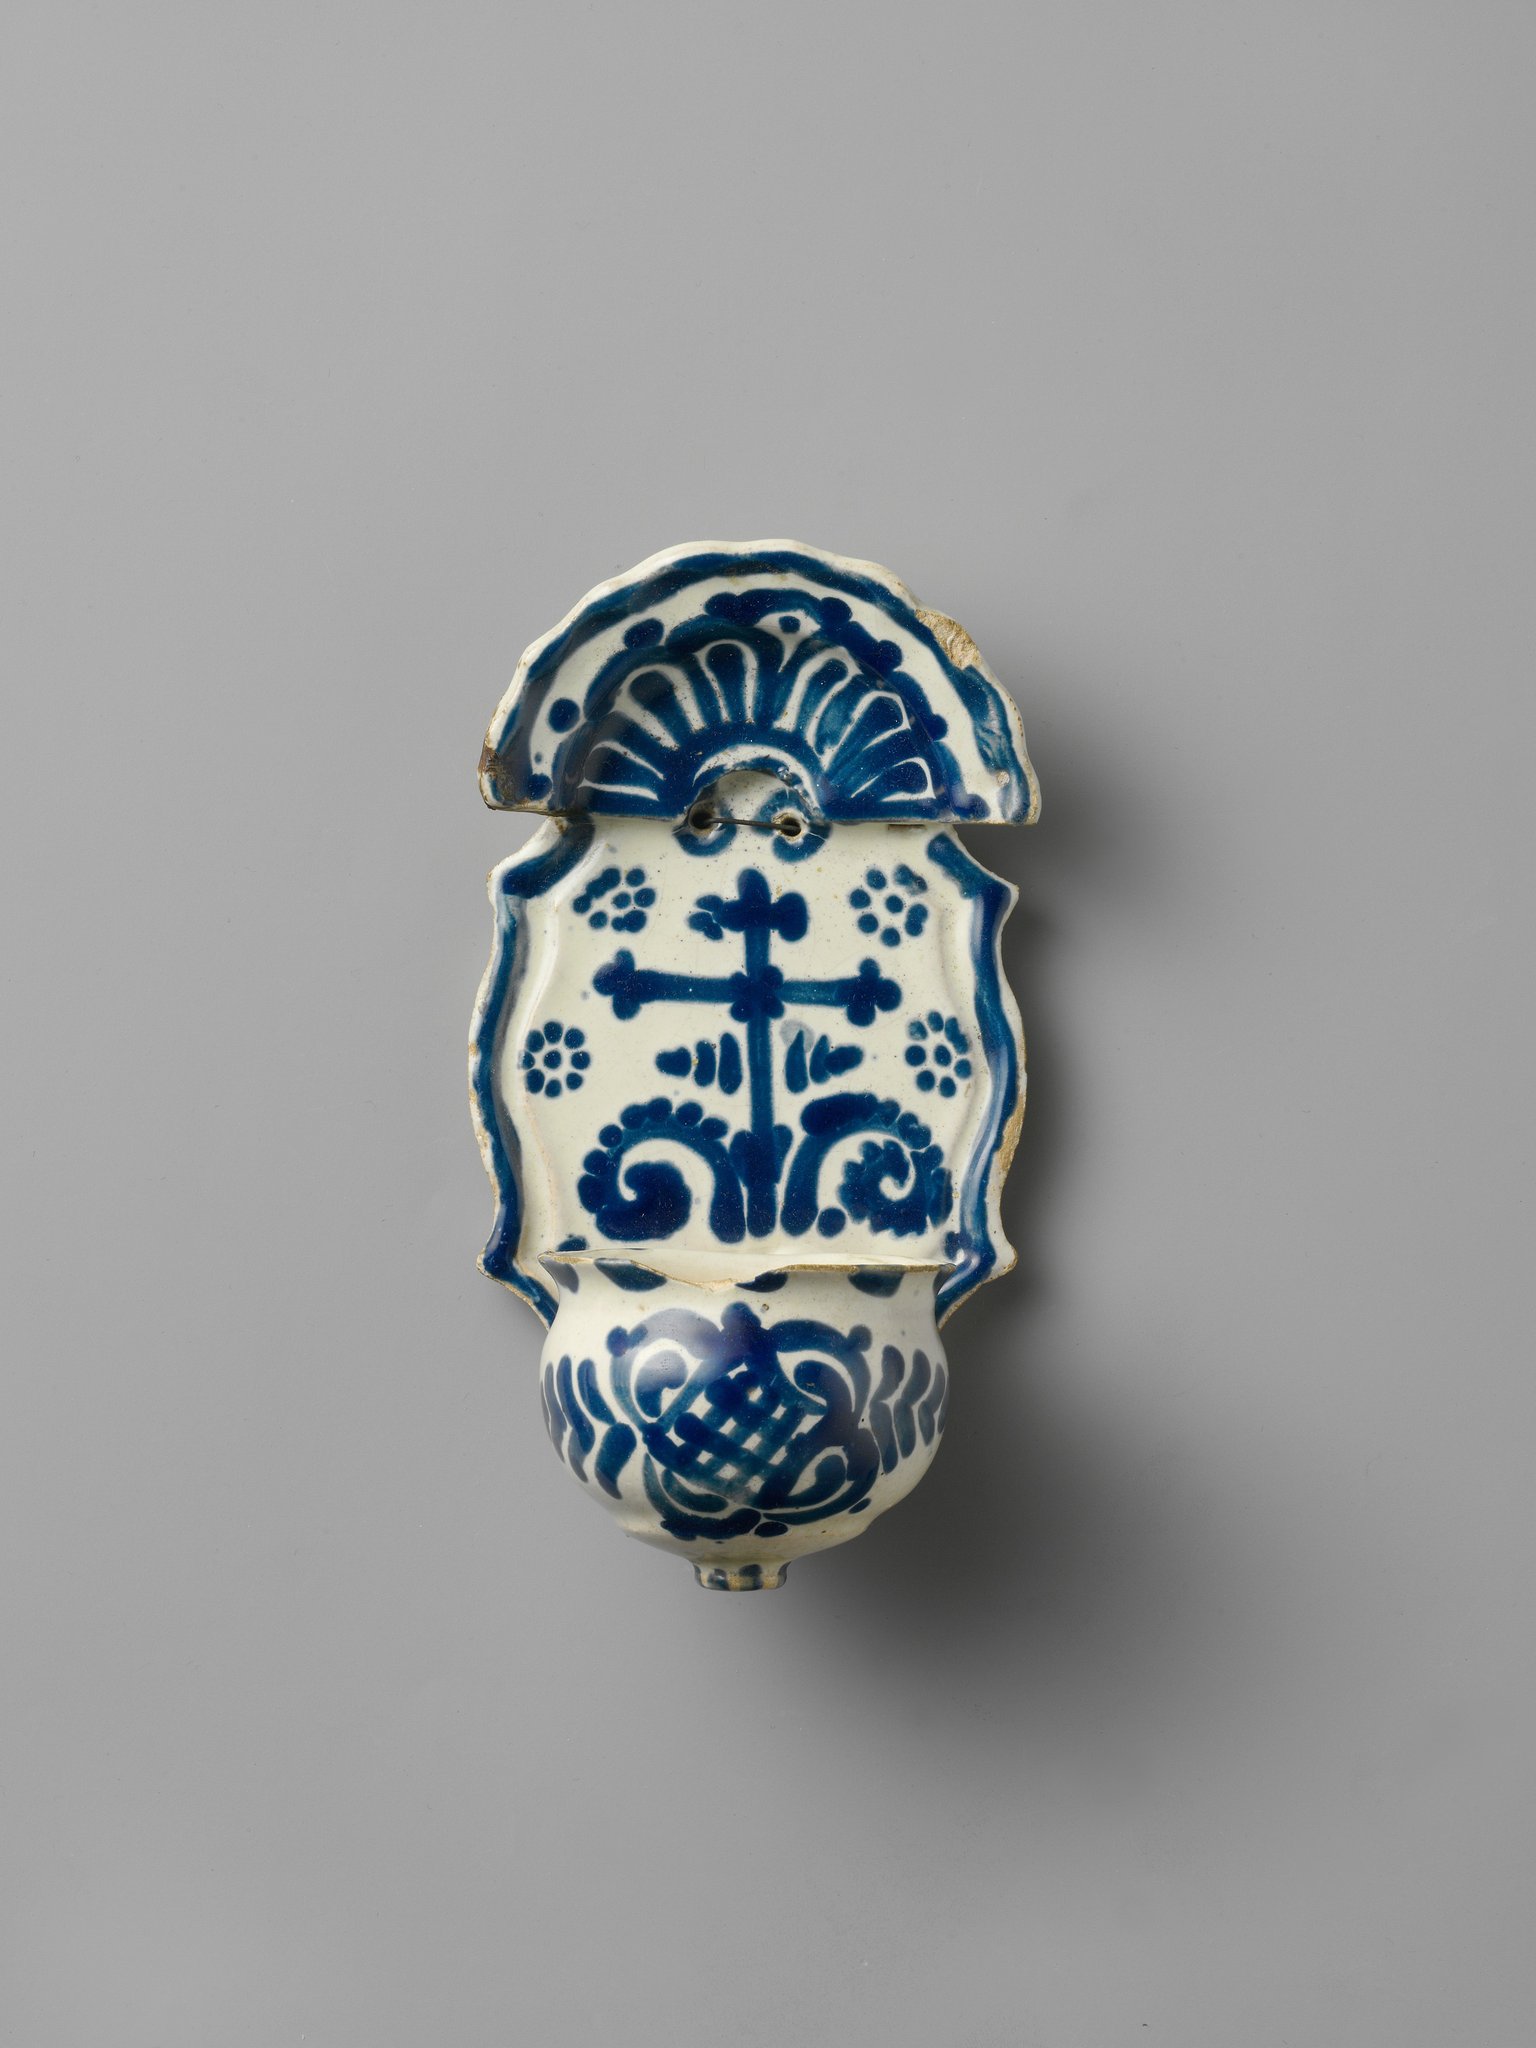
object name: holy water basin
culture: mexican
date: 1800-1900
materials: earthenware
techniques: glazing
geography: mexico